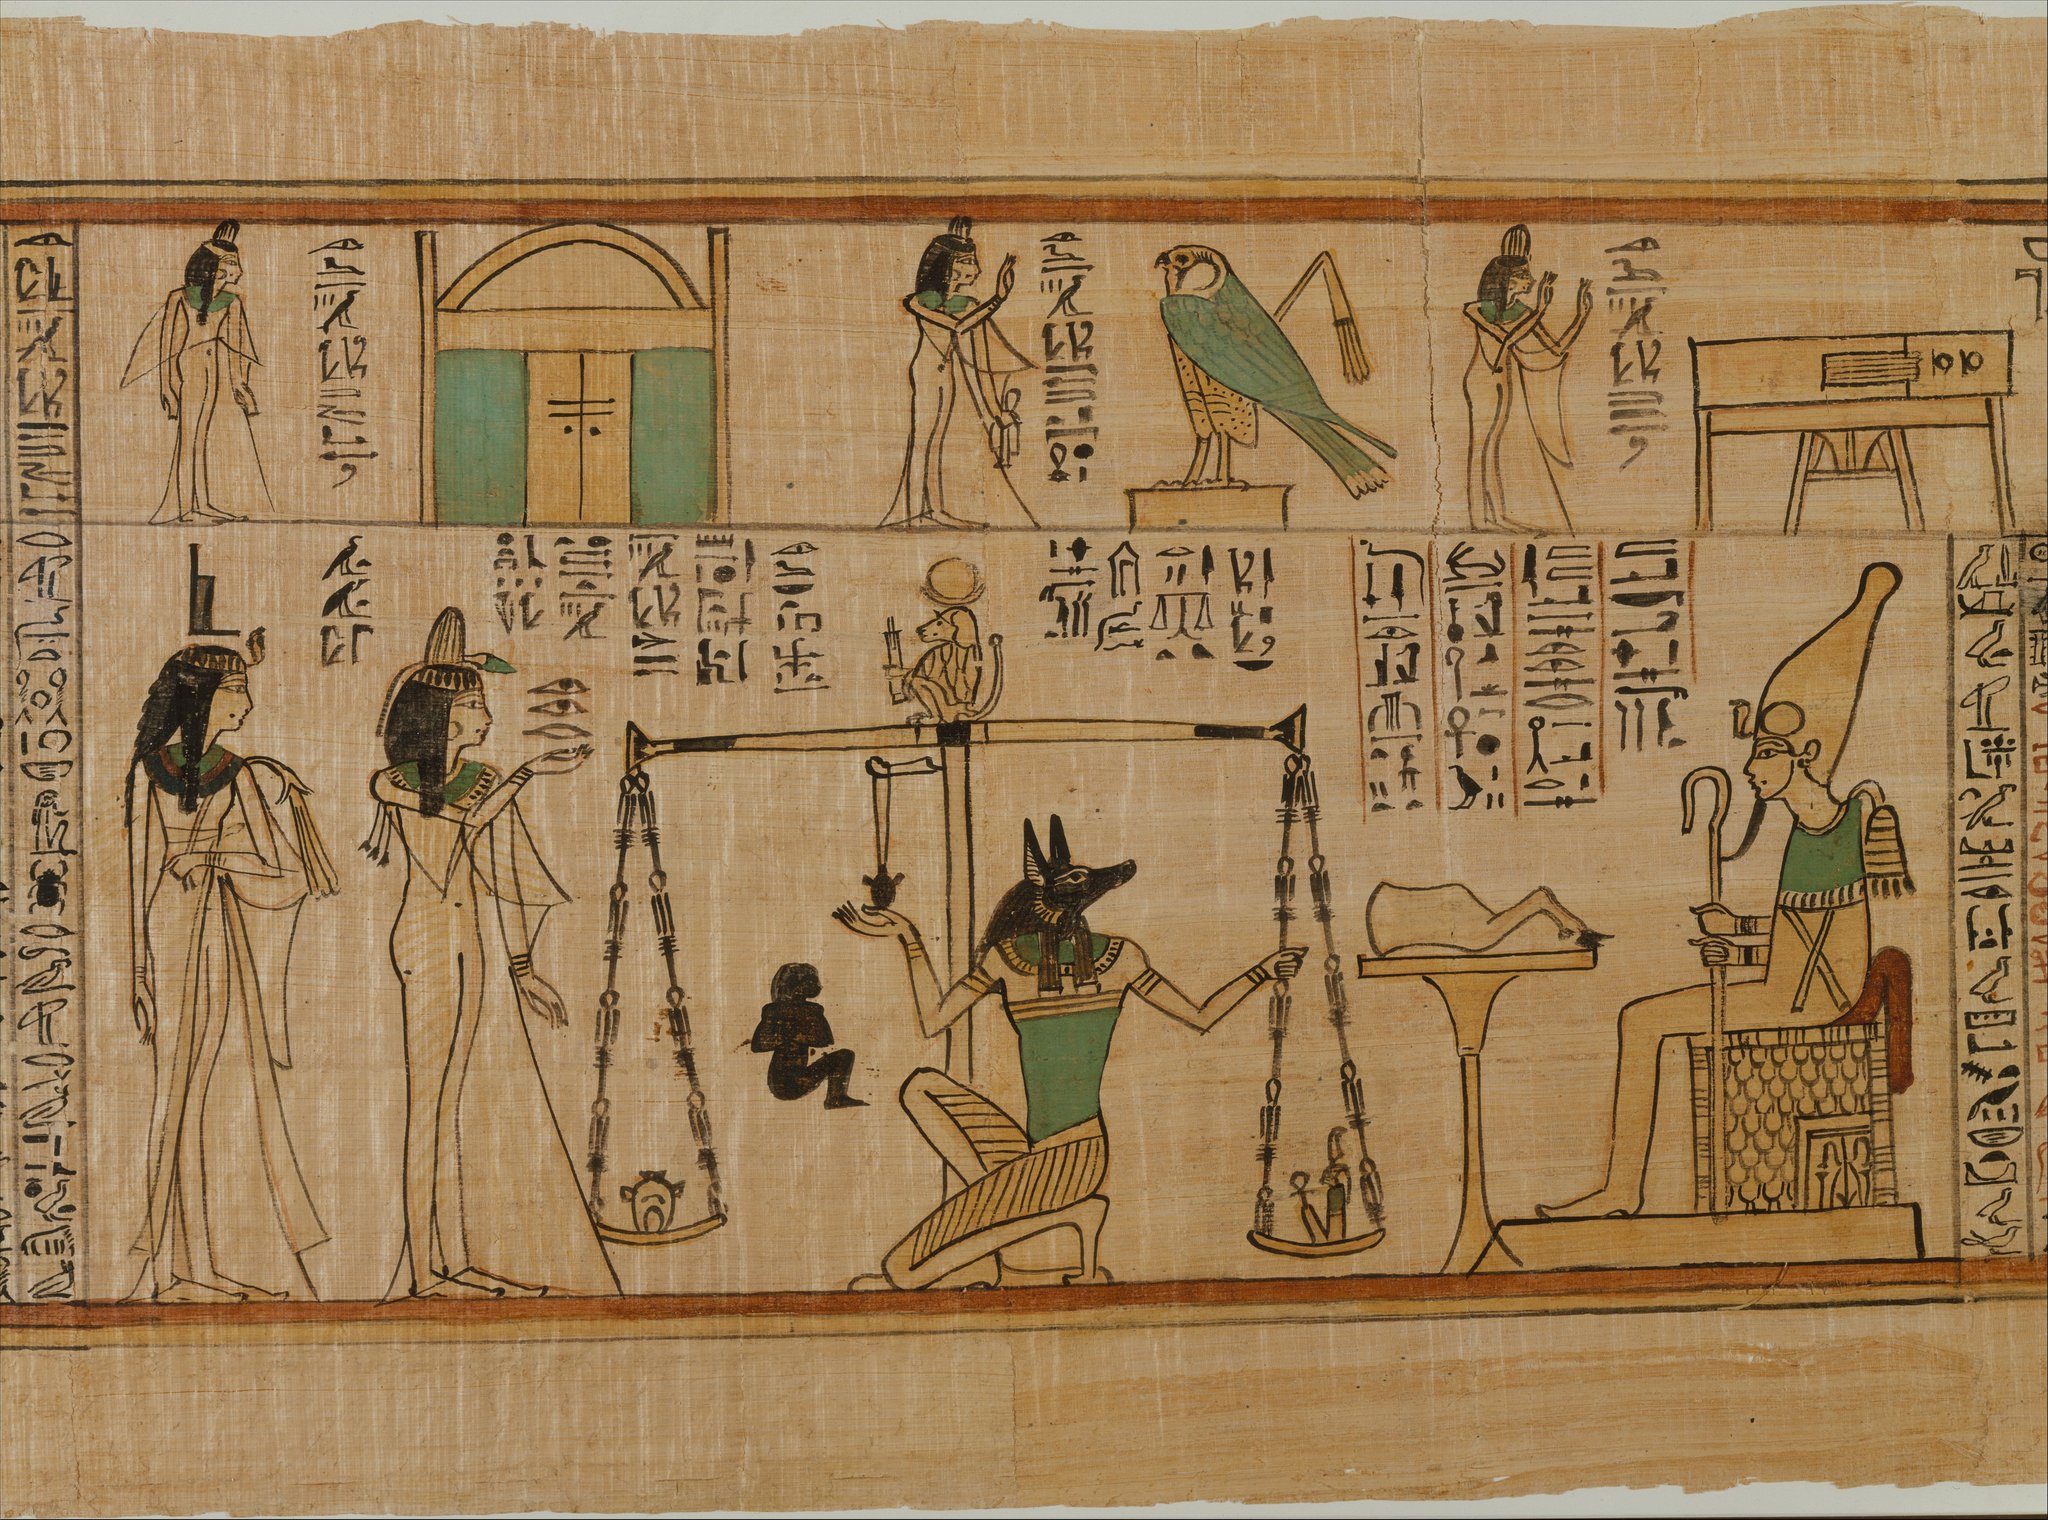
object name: papyrus, funerary, book of the dead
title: Book of the Dead for the Chantress of Amun Nauny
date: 1050 BCE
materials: paint, papyrus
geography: egypt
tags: hieroglyphs,anubis,horus,isis